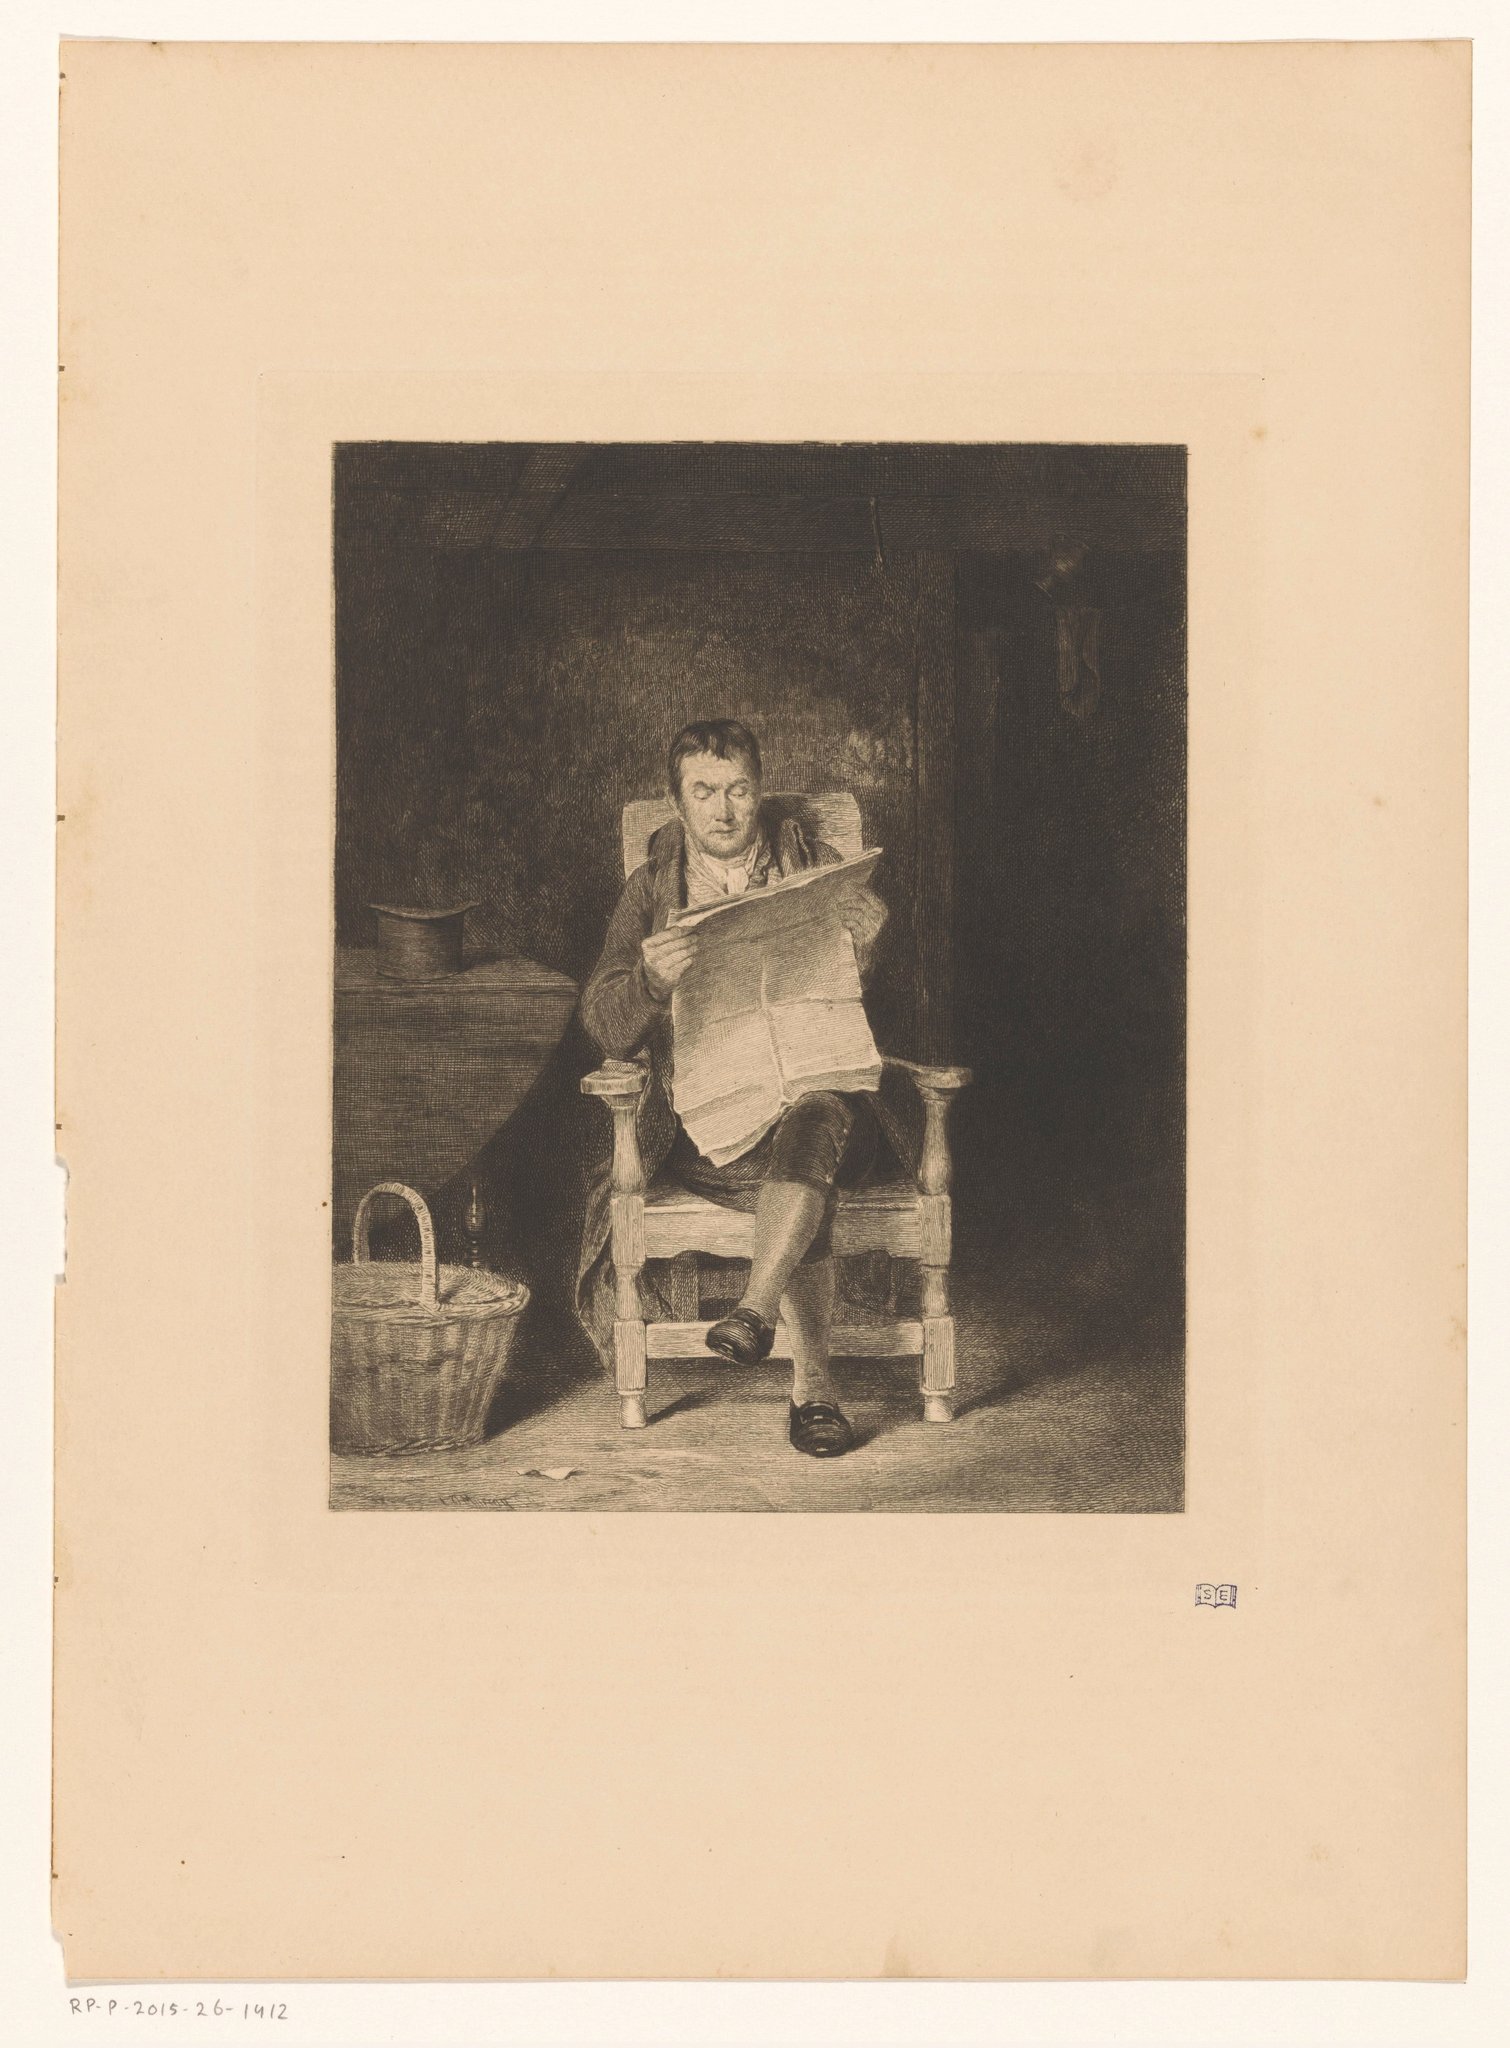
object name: print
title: Man leest de krant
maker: charles oliver murray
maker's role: print maker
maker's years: 1842-1923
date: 1852-1923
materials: paper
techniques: etching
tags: reading, newspaper, news-sheet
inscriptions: collector's mark: Lugt 4780, collector's mark: Lugt 2228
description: Prent naar het schilderij van Thomas Sword Good uit ca. 1827, tegenwoordig in de Tate Gallery (N00378). Waarschijnlijk een illustratie uit een boek of tijdschrift.